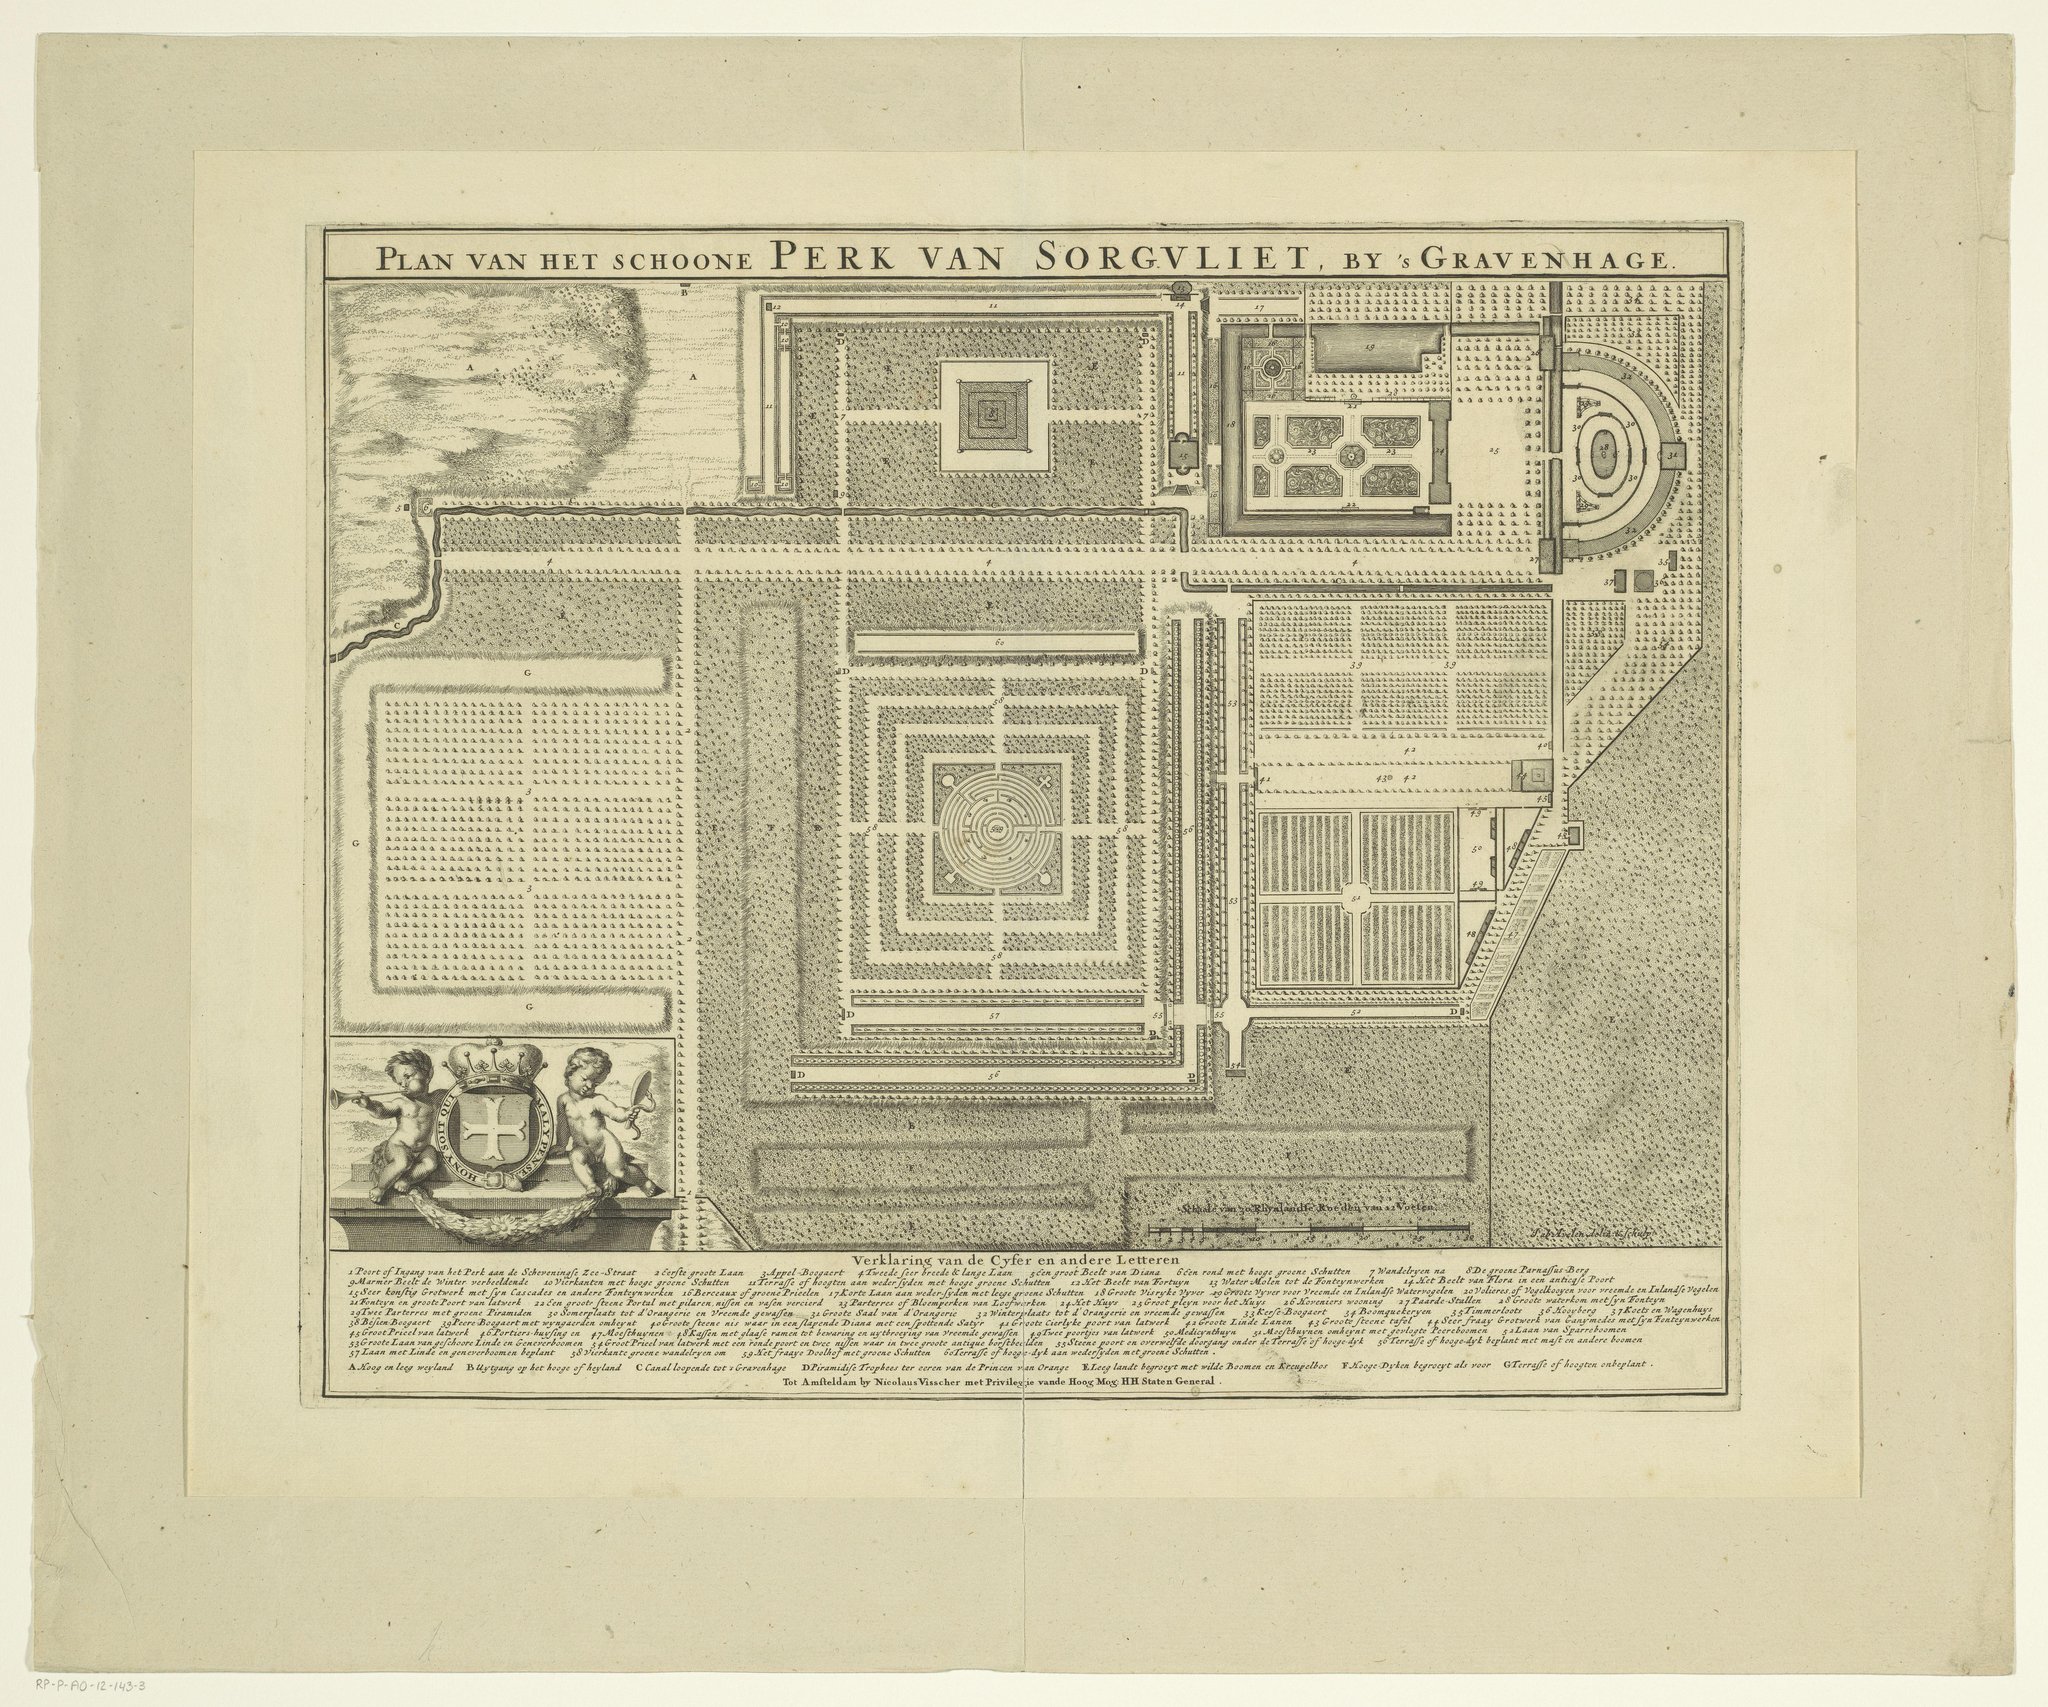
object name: print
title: Plan van het schoone Perk van Sorgvliet, by 's Gravenhage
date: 1691-1698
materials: paper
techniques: engraving, etching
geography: northern netherlands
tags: plan, map of garden, knighthood order (garter) - insignia of a knighthood order, e.g.: badge, chain, the hague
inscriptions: collector's mark: Lugt 2228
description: Plattegrond van Zorgvliet, met legenda van 1-60 binnen het park en A-G buiten het park. Linksonder een het wapen van de Orde van de Kousenband. Rechts van het midden een schaalstok: Schaale van 30 Rhynlandse roeden van 12 voeten.